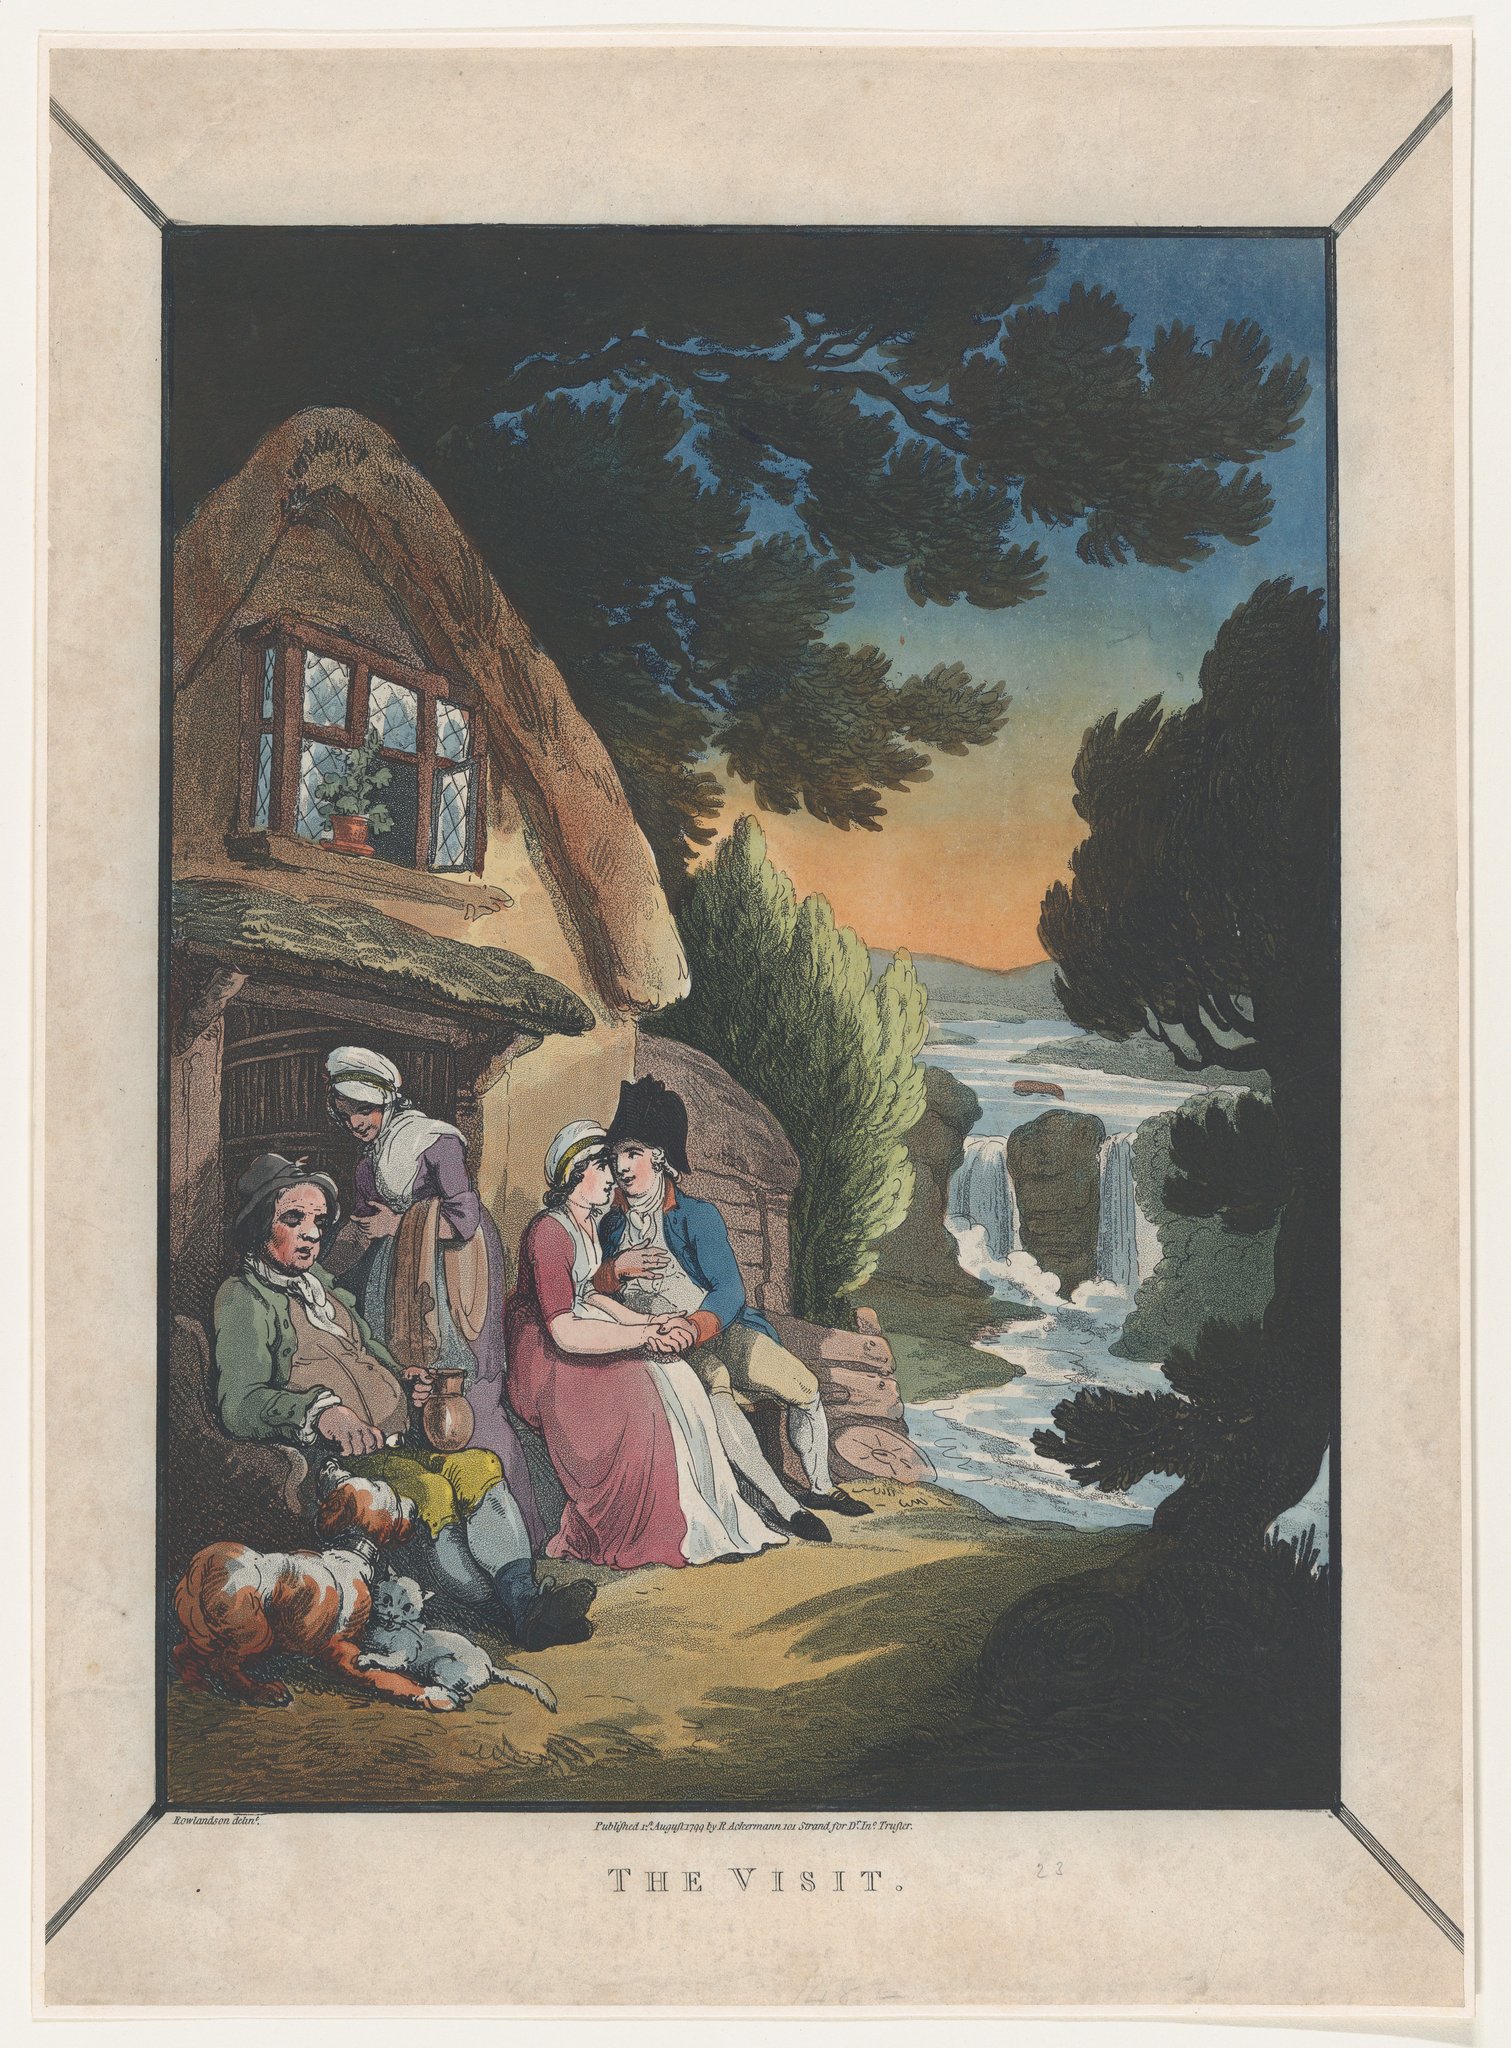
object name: print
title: The Visit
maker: thomas rowlandson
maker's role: artist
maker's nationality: british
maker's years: 1757-1827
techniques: aquatint, etching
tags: houses,couples,men,women,dogs